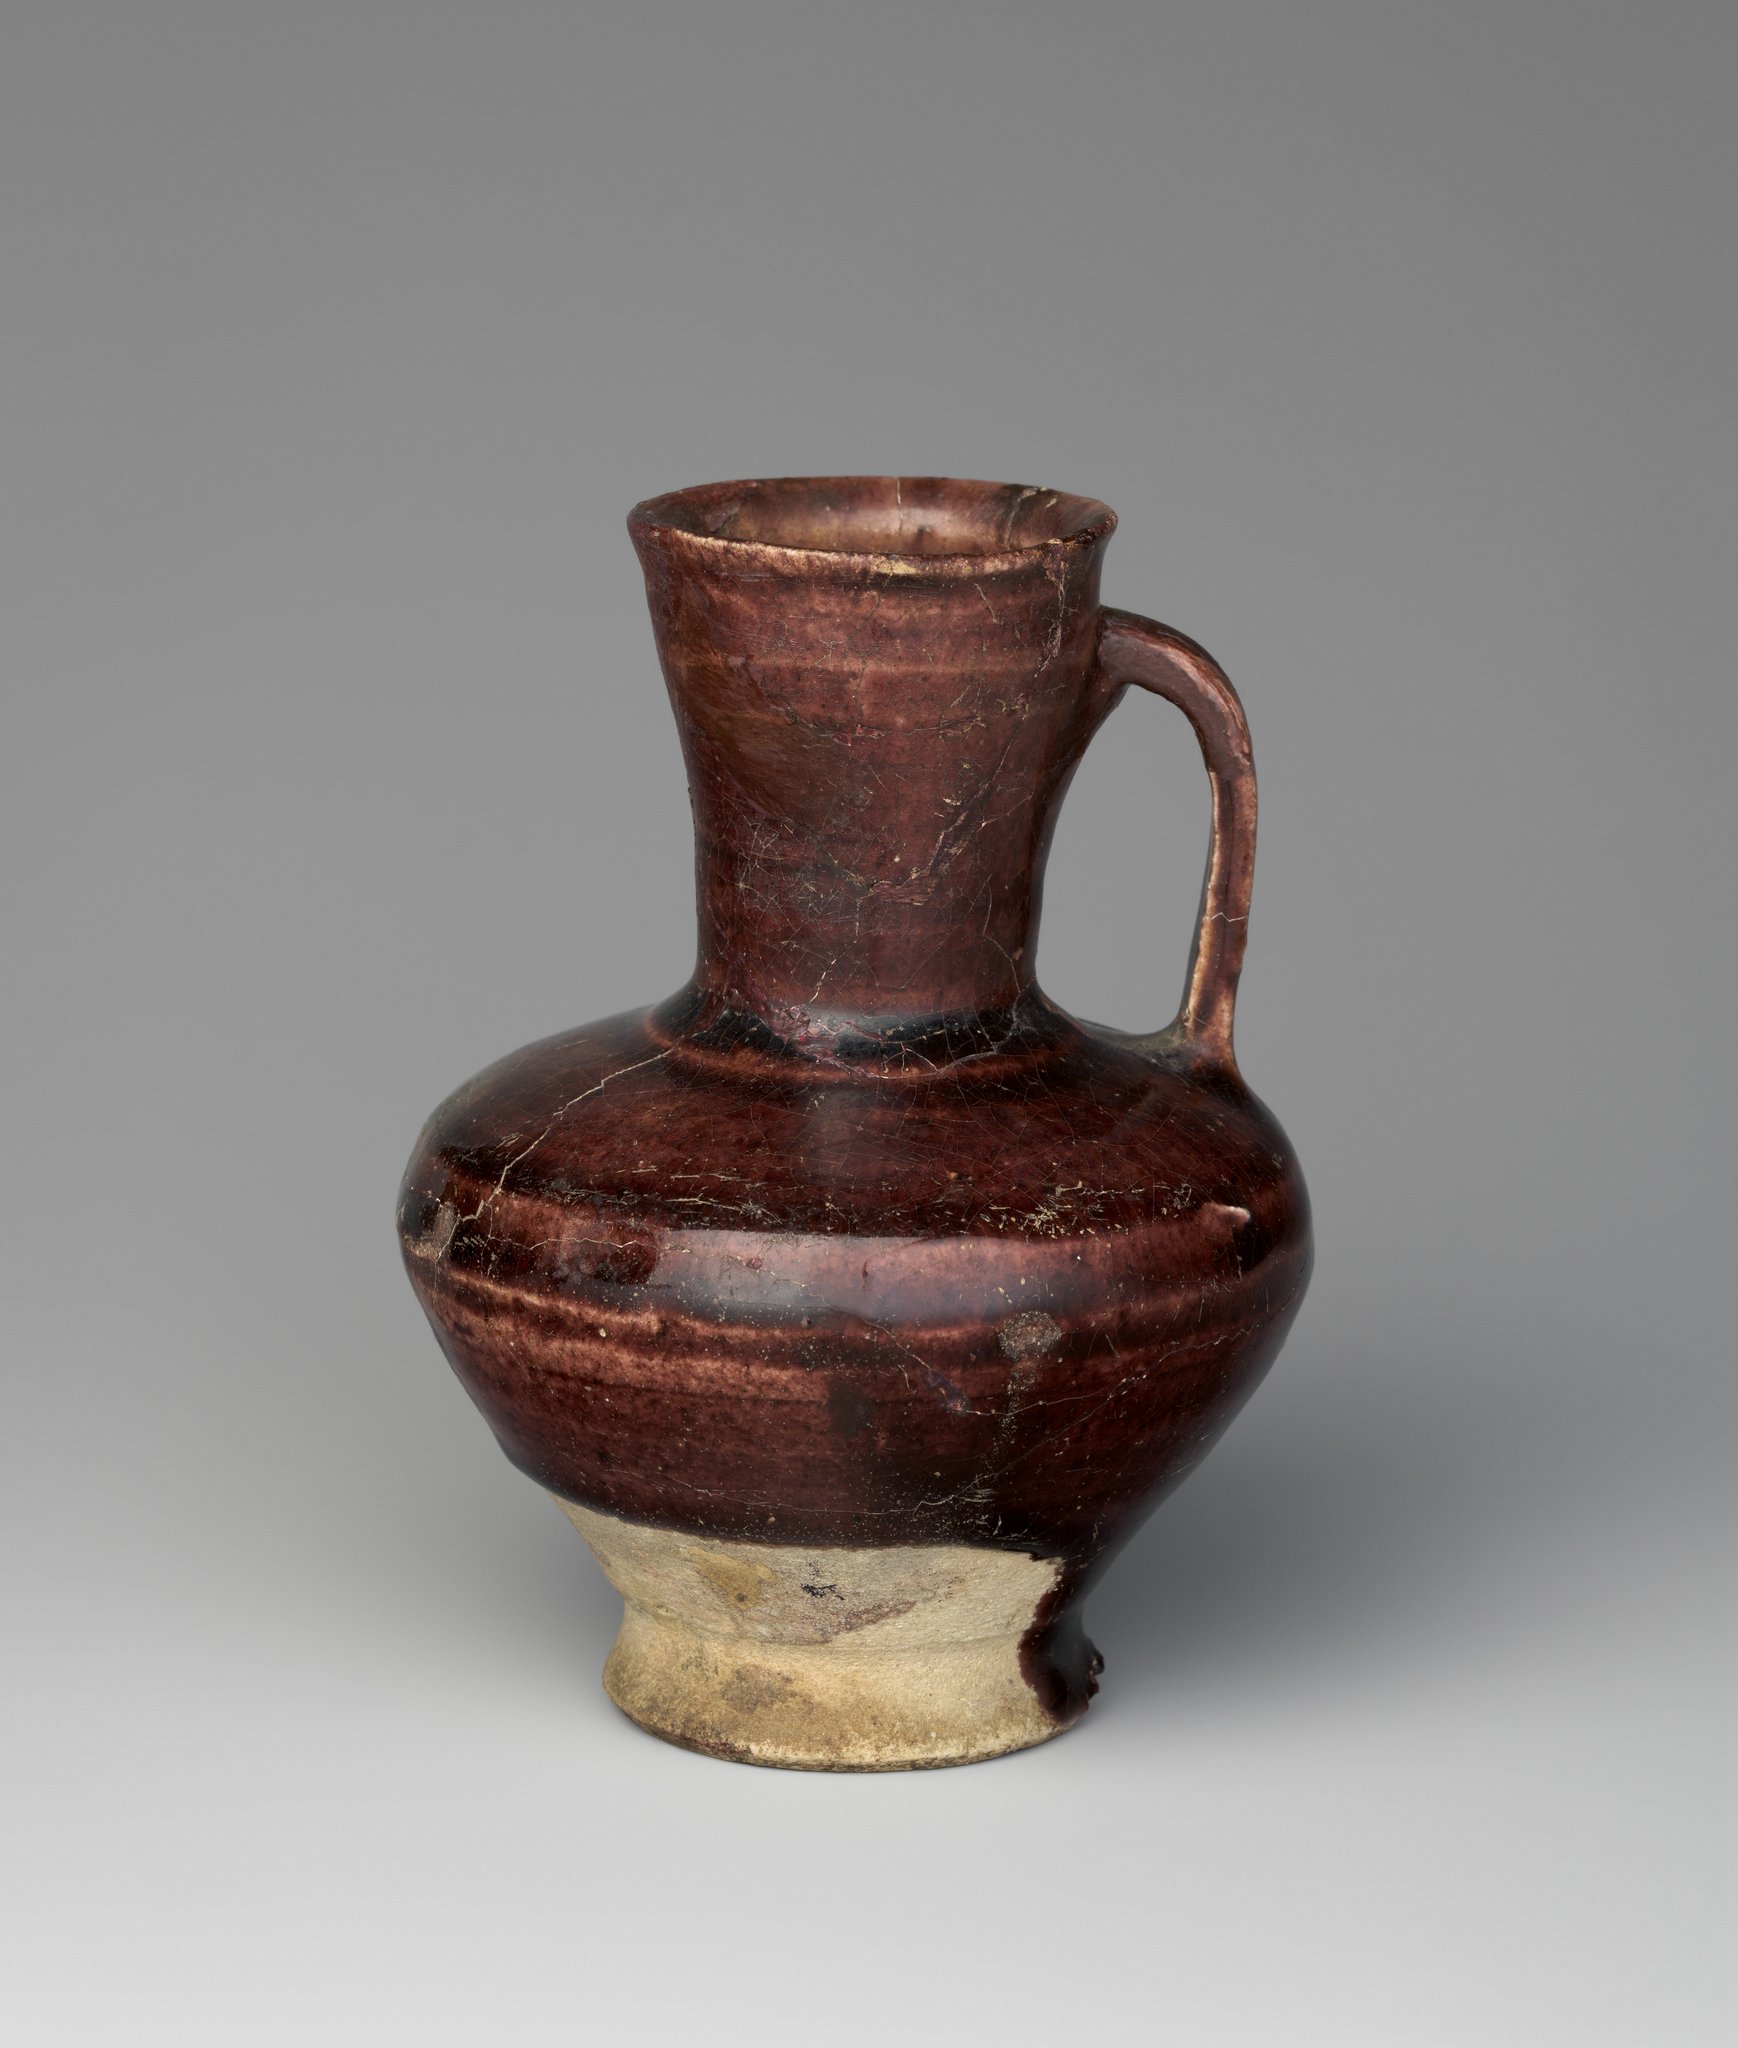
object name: ewer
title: Miniature Ewer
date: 1001-1200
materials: stonepaste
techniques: glazing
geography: iran